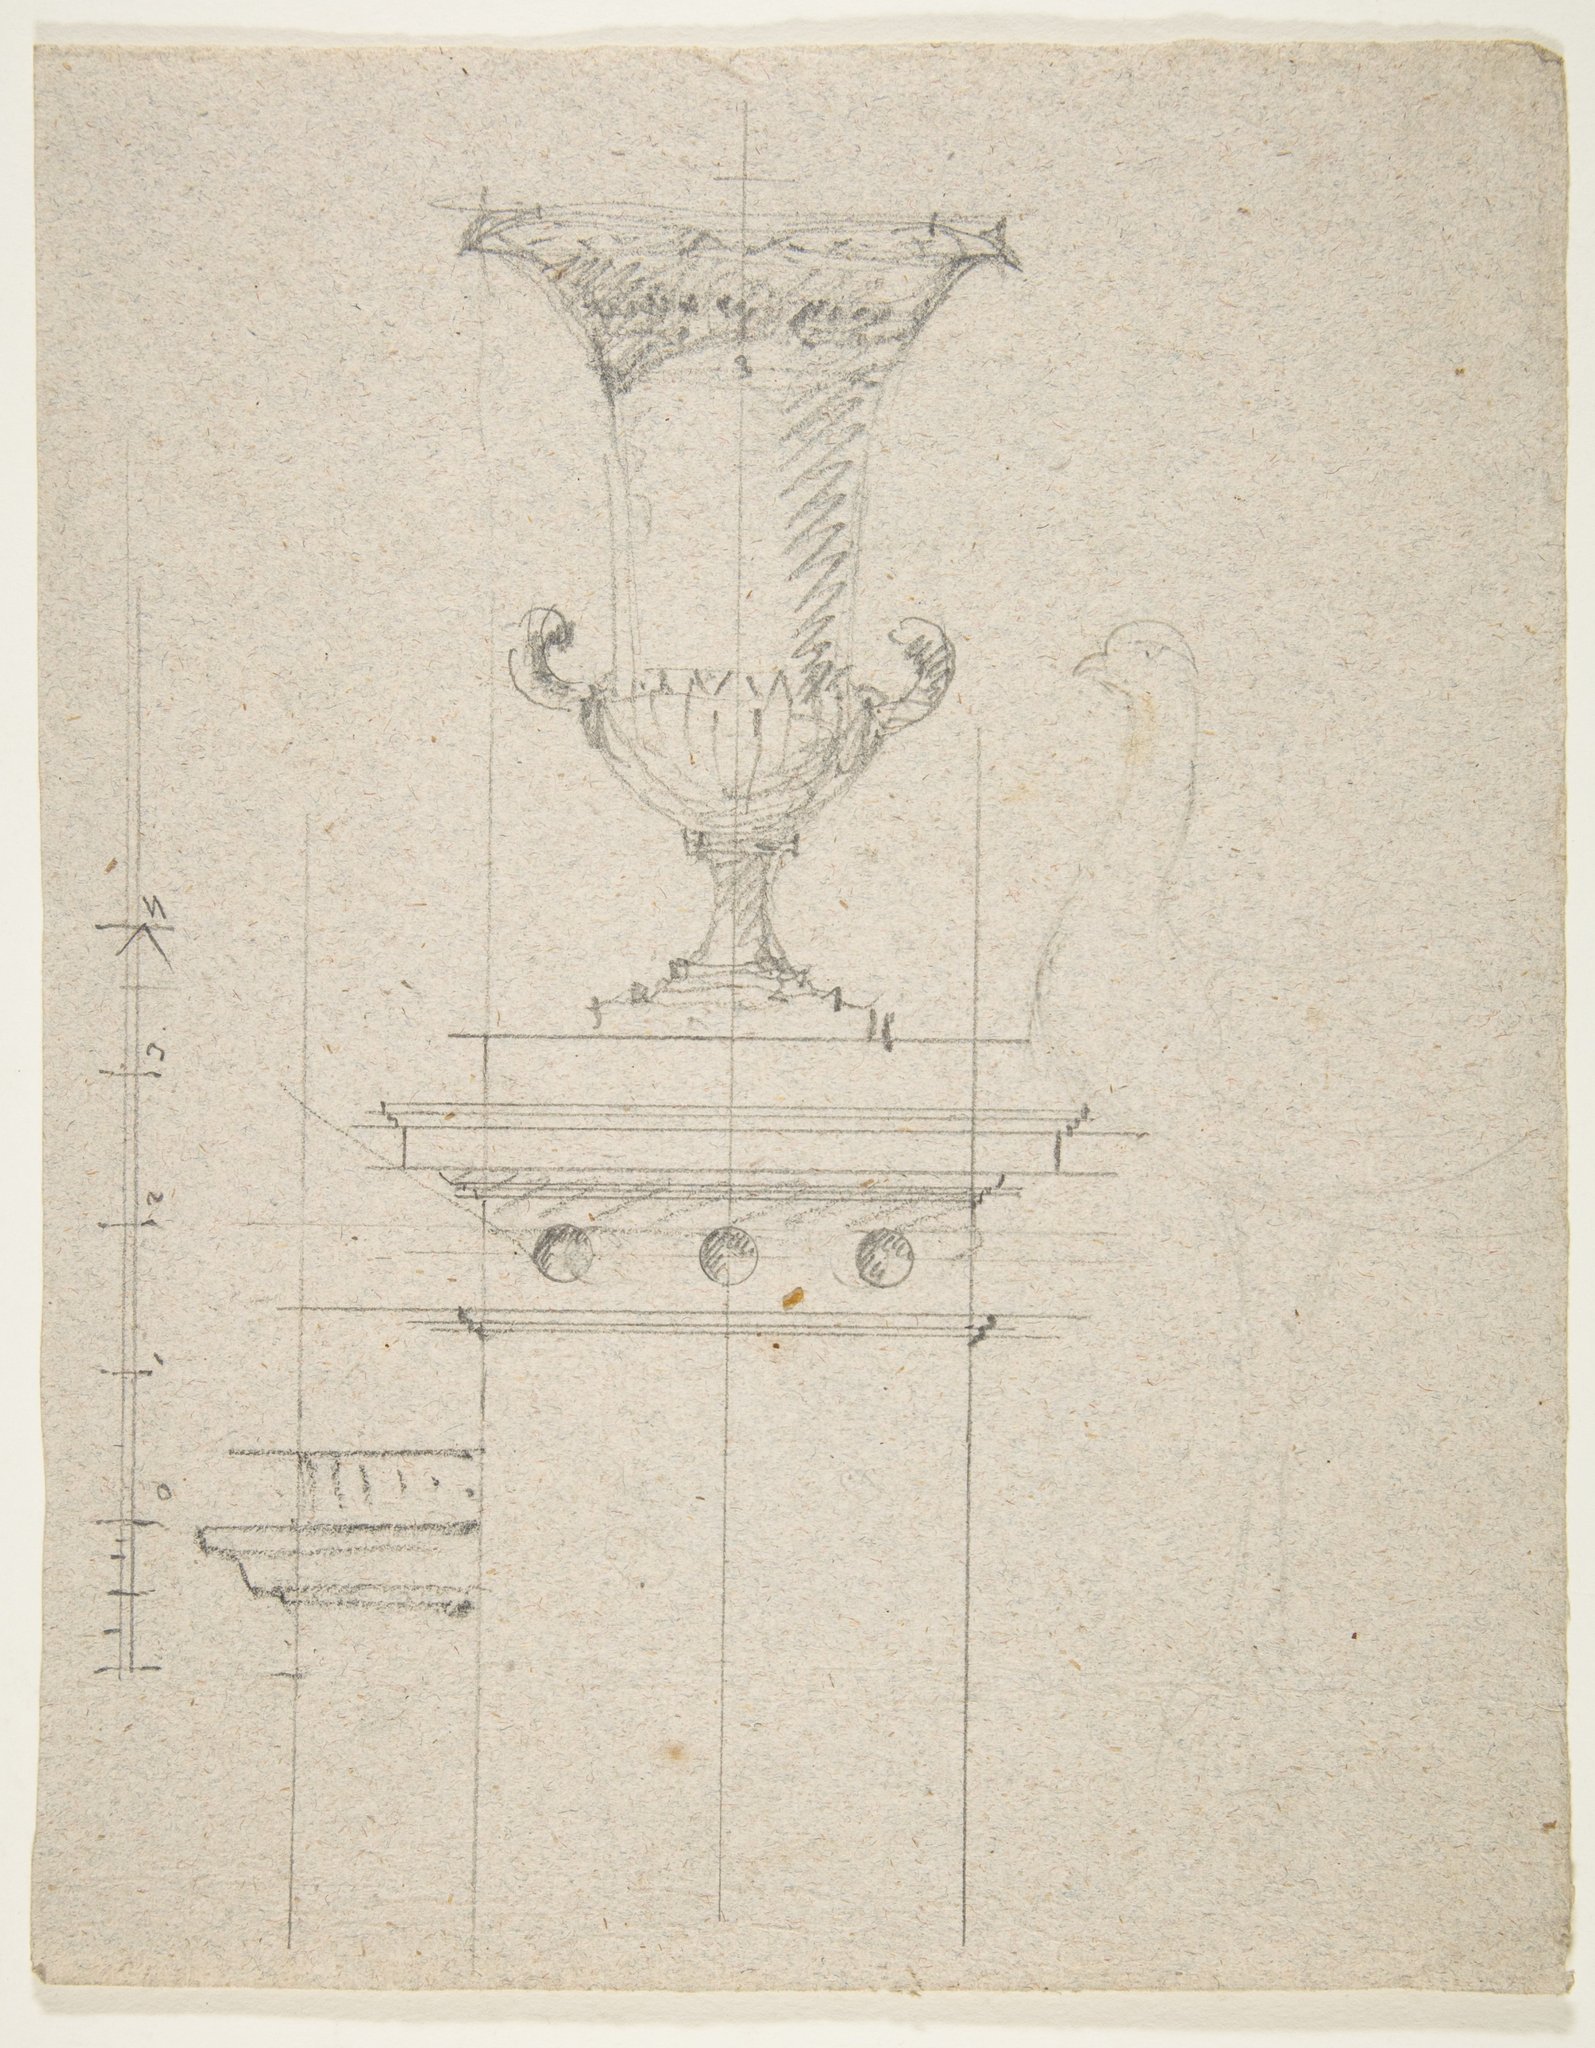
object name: drawing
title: Design for an urn (verso); Designs for two urns (recto)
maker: anonymous, french, 19th century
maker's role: artist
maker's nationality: french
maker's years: 1800-1900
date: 1801-1900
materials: chalk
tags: urns